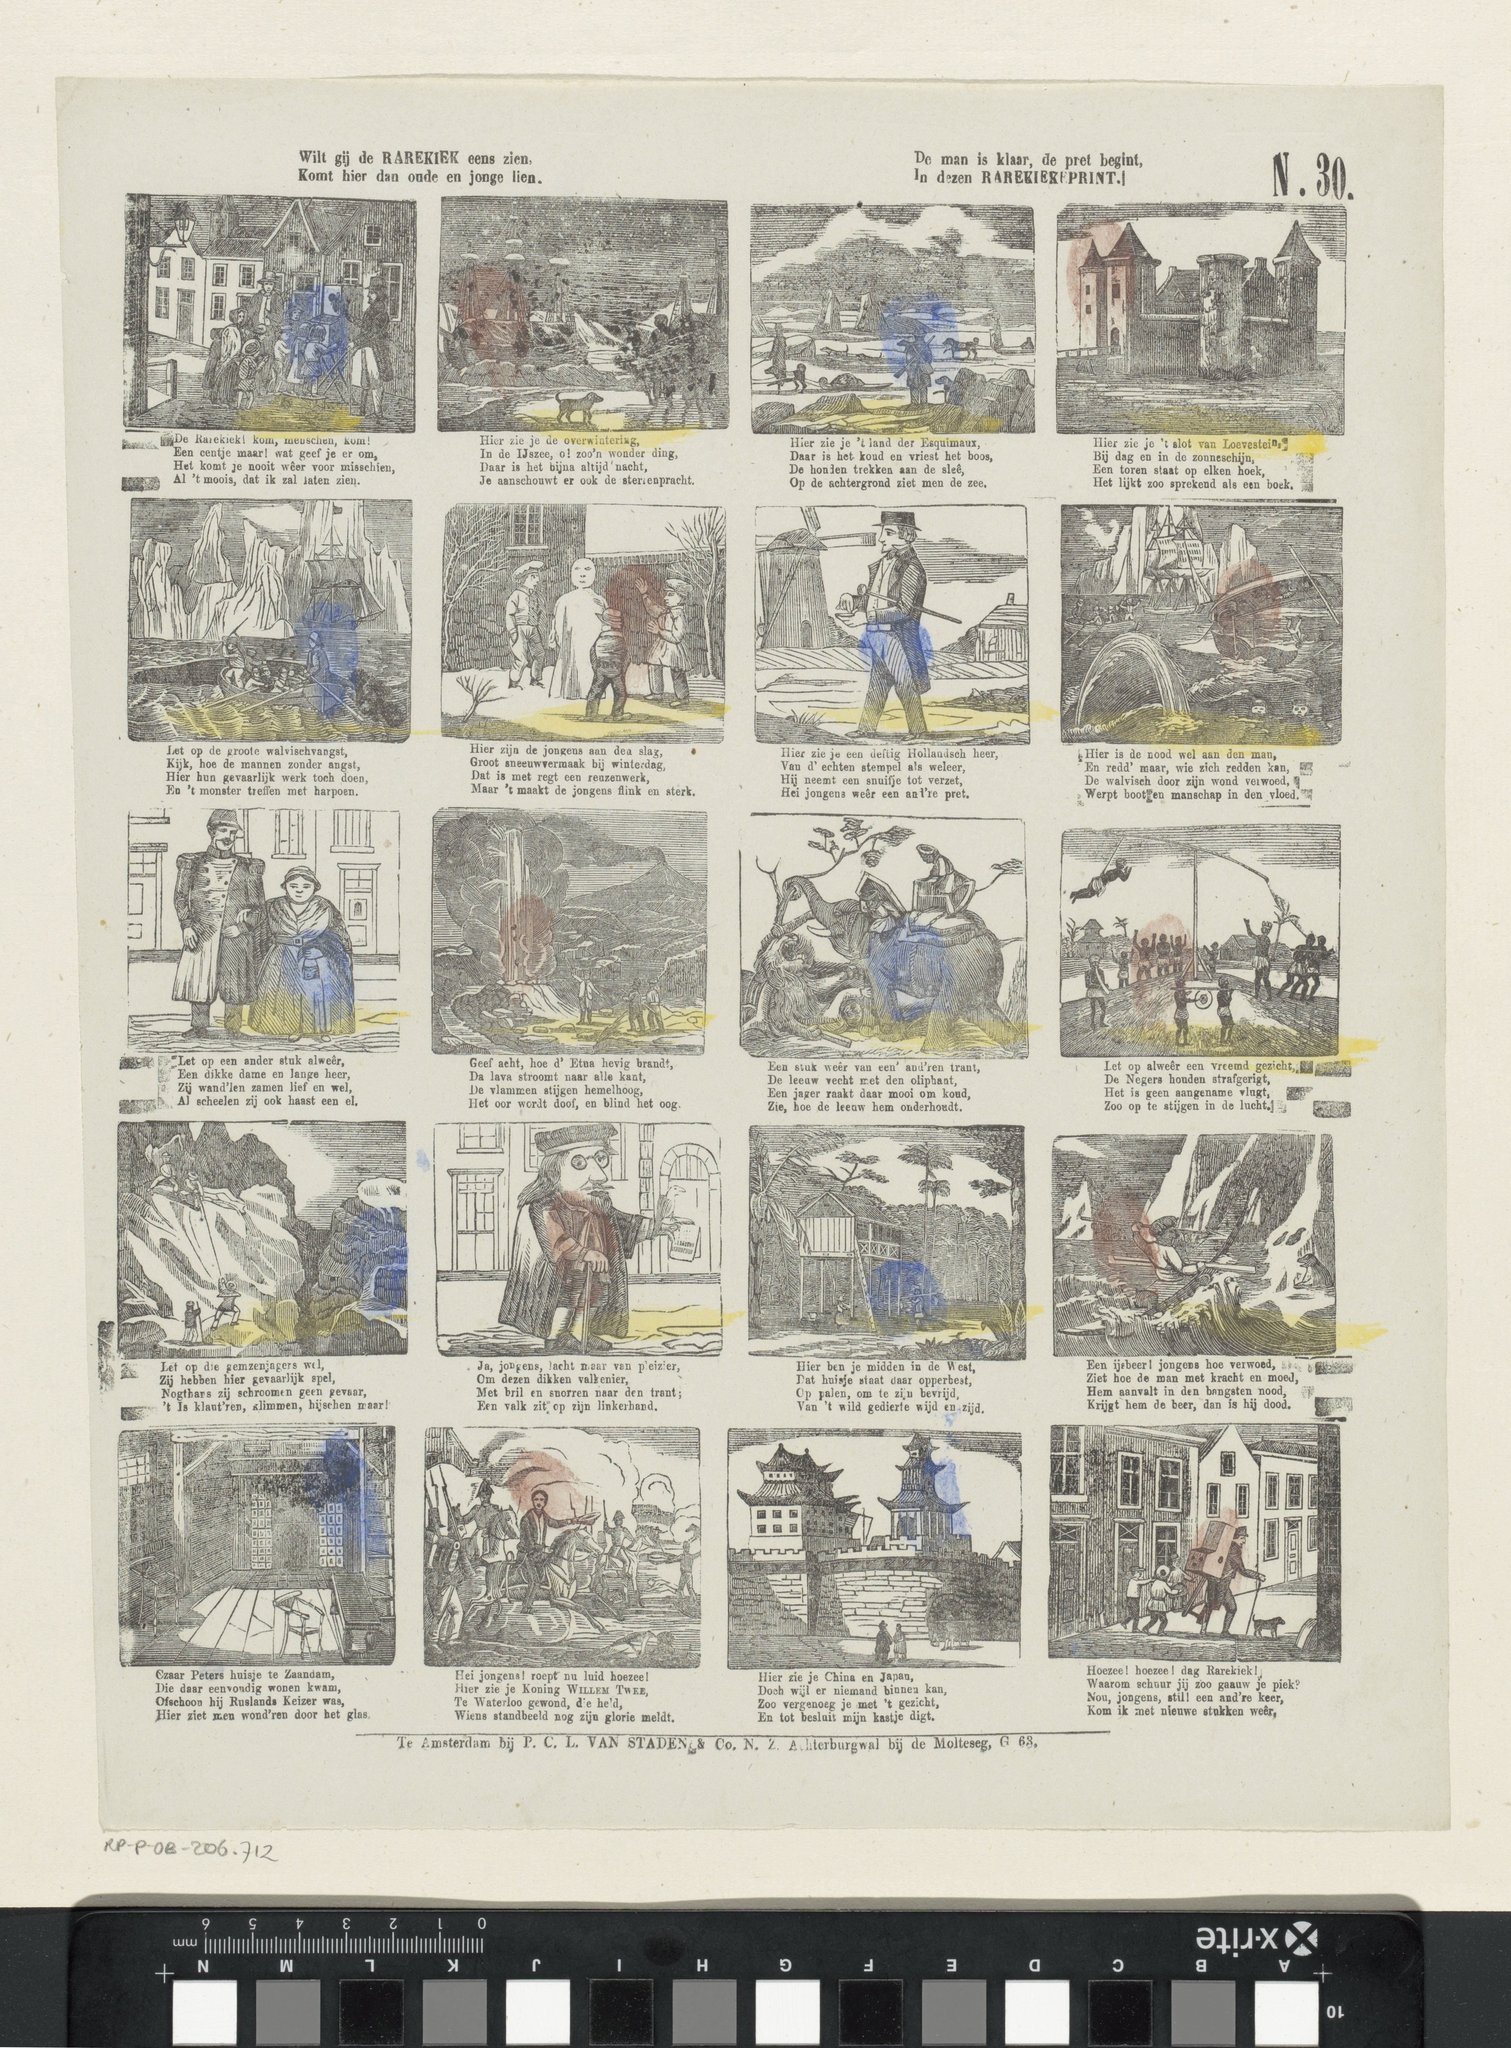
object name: print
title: Wilt gij de rarekiek eens zien, / Komt hier dan, oude en jonge liên. / De man is klaar, de pret begint,/ In deze rarekiekenprint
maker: Anonymous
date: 1850-1870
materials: paper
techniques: colour, letterpress printing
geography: netherlands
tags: (making a) snowman, drowning, shipwrecked person, trunked animals: elephant, swimming mammals: whale, loevestein castle, china, japan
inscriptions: collector's mark: Lugt 2760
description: Blad met 20 voorstellingen van verschillende aard, zoals voorstellingen van Slot Loevestein, van kinderen die een sneeuwpop maken en van een valkenier. Onder elke afbeelding een vierregelig vers. Genummerd rechtsboven: N. 30.